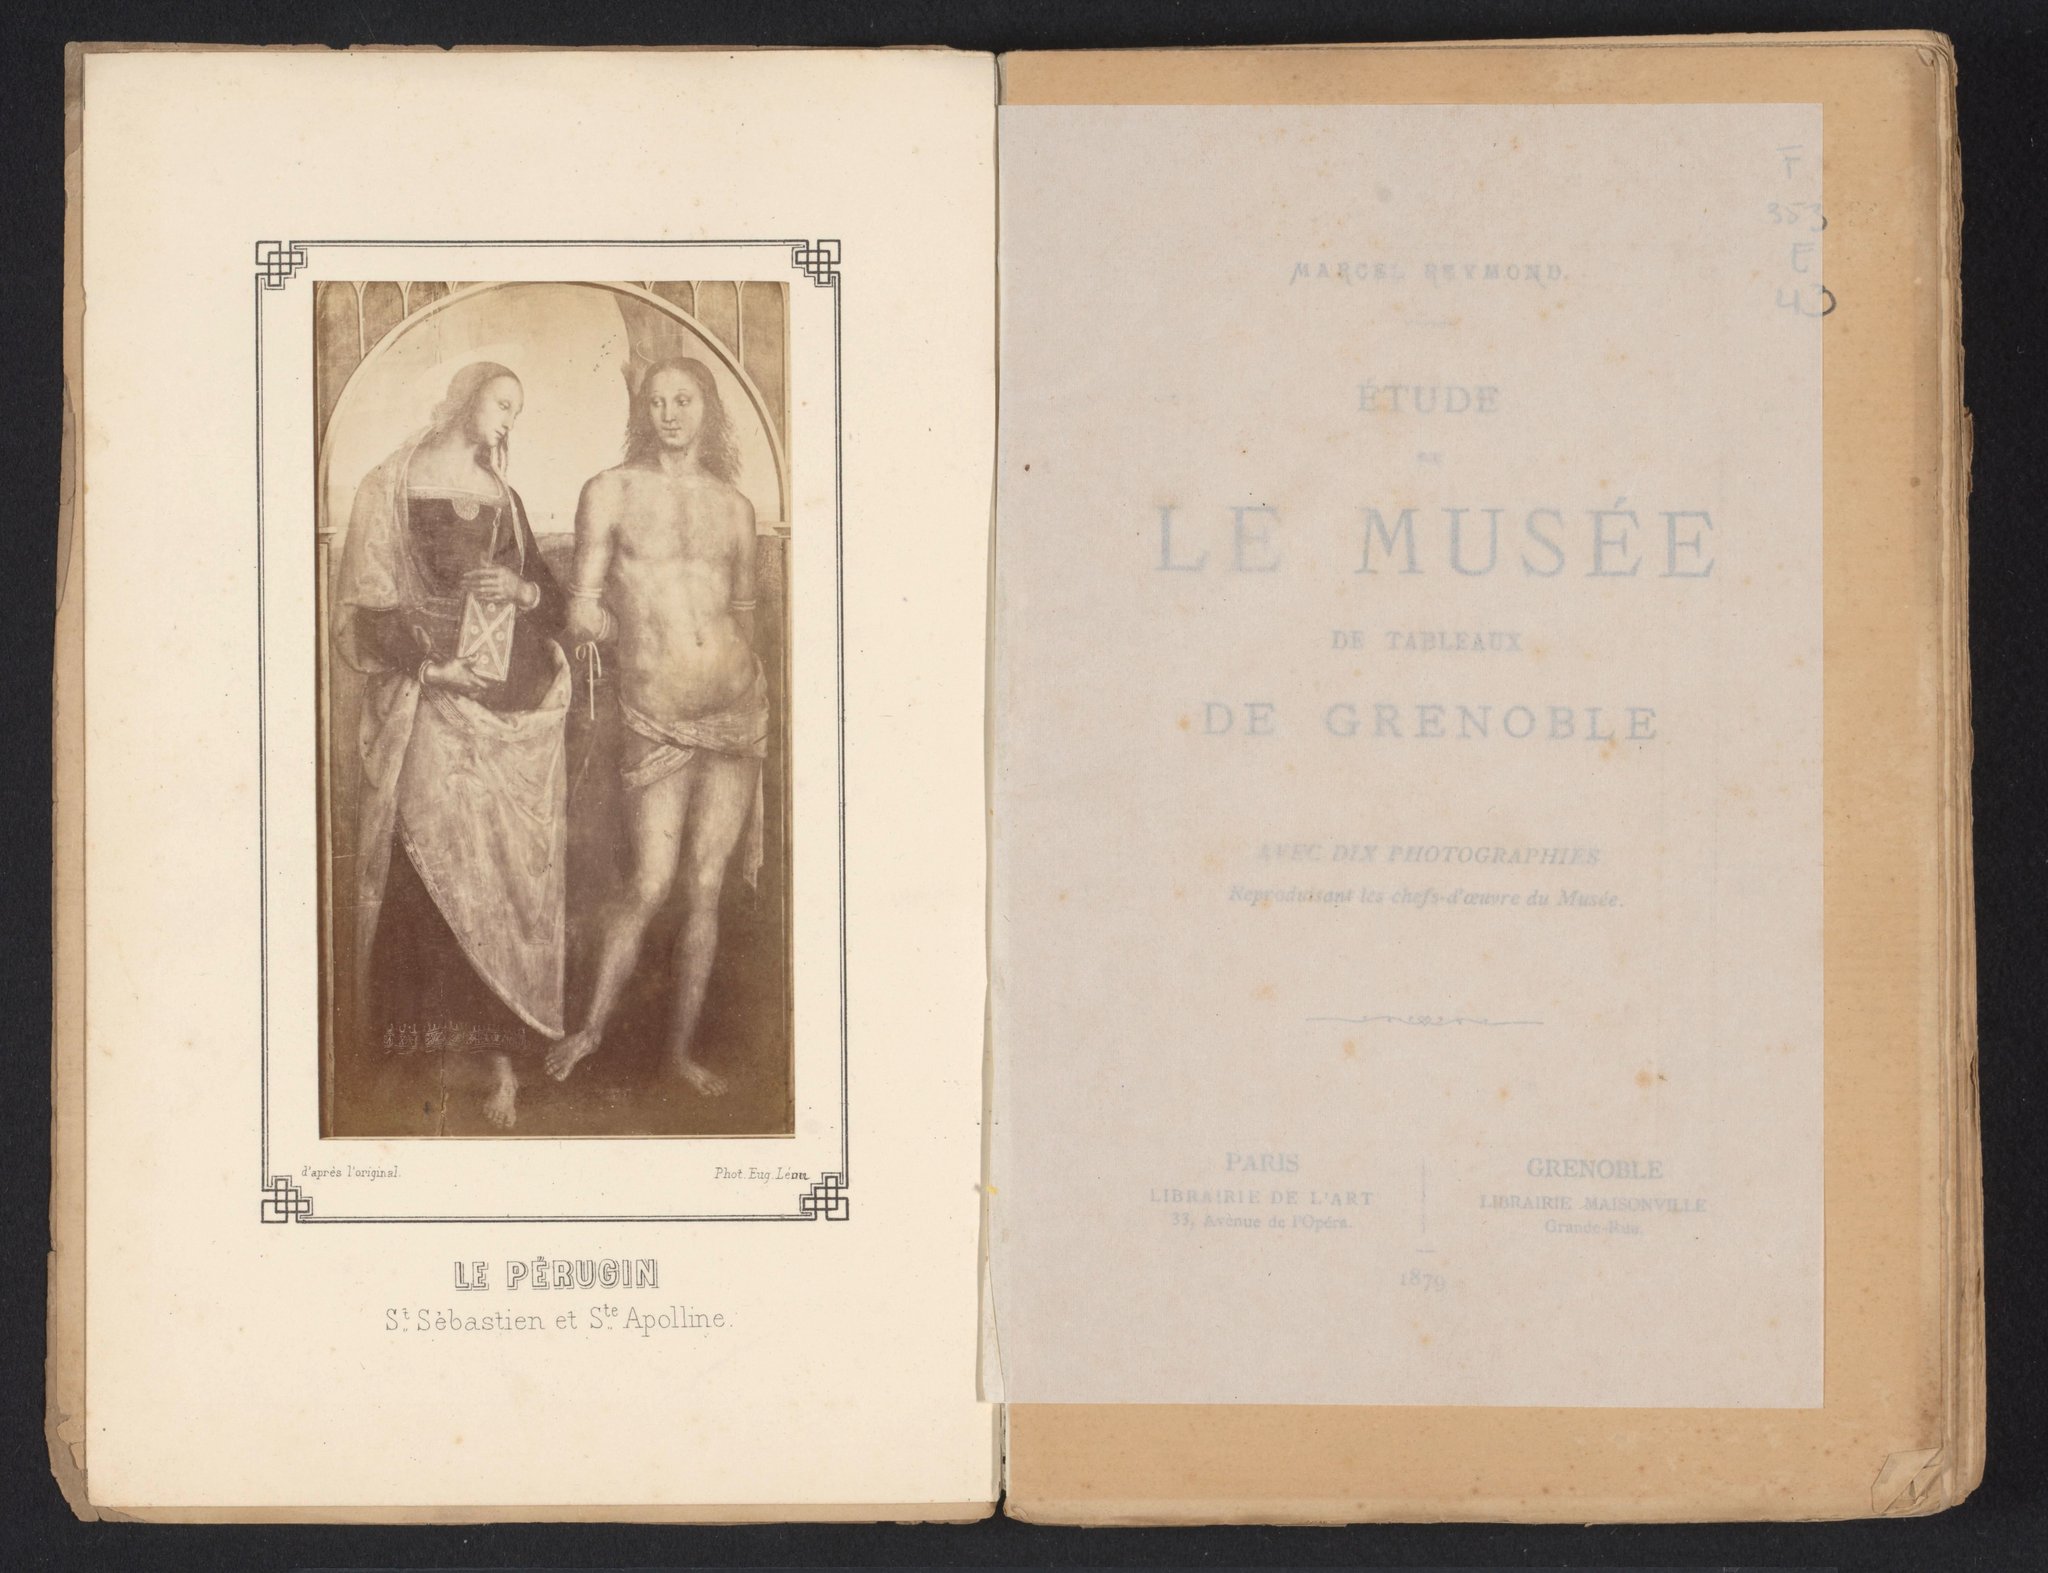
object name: page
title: Fotoreproductie van het schilderij Saint Sébastien et sainte Apolline door Pietro Perugino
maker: e. léon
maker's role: fotograaf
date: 1869-1879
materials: photographic support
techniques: albumen print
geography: grenoble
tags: the martyr sebastian; possible attributes: arrow(s), bow, tree-trunk, the virgin martyr apollonia of alexandria; possible attributes: book, crown, palm-branch, tooth in pincers, picture, painting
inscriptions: inscription: ‘d'après l'original.’